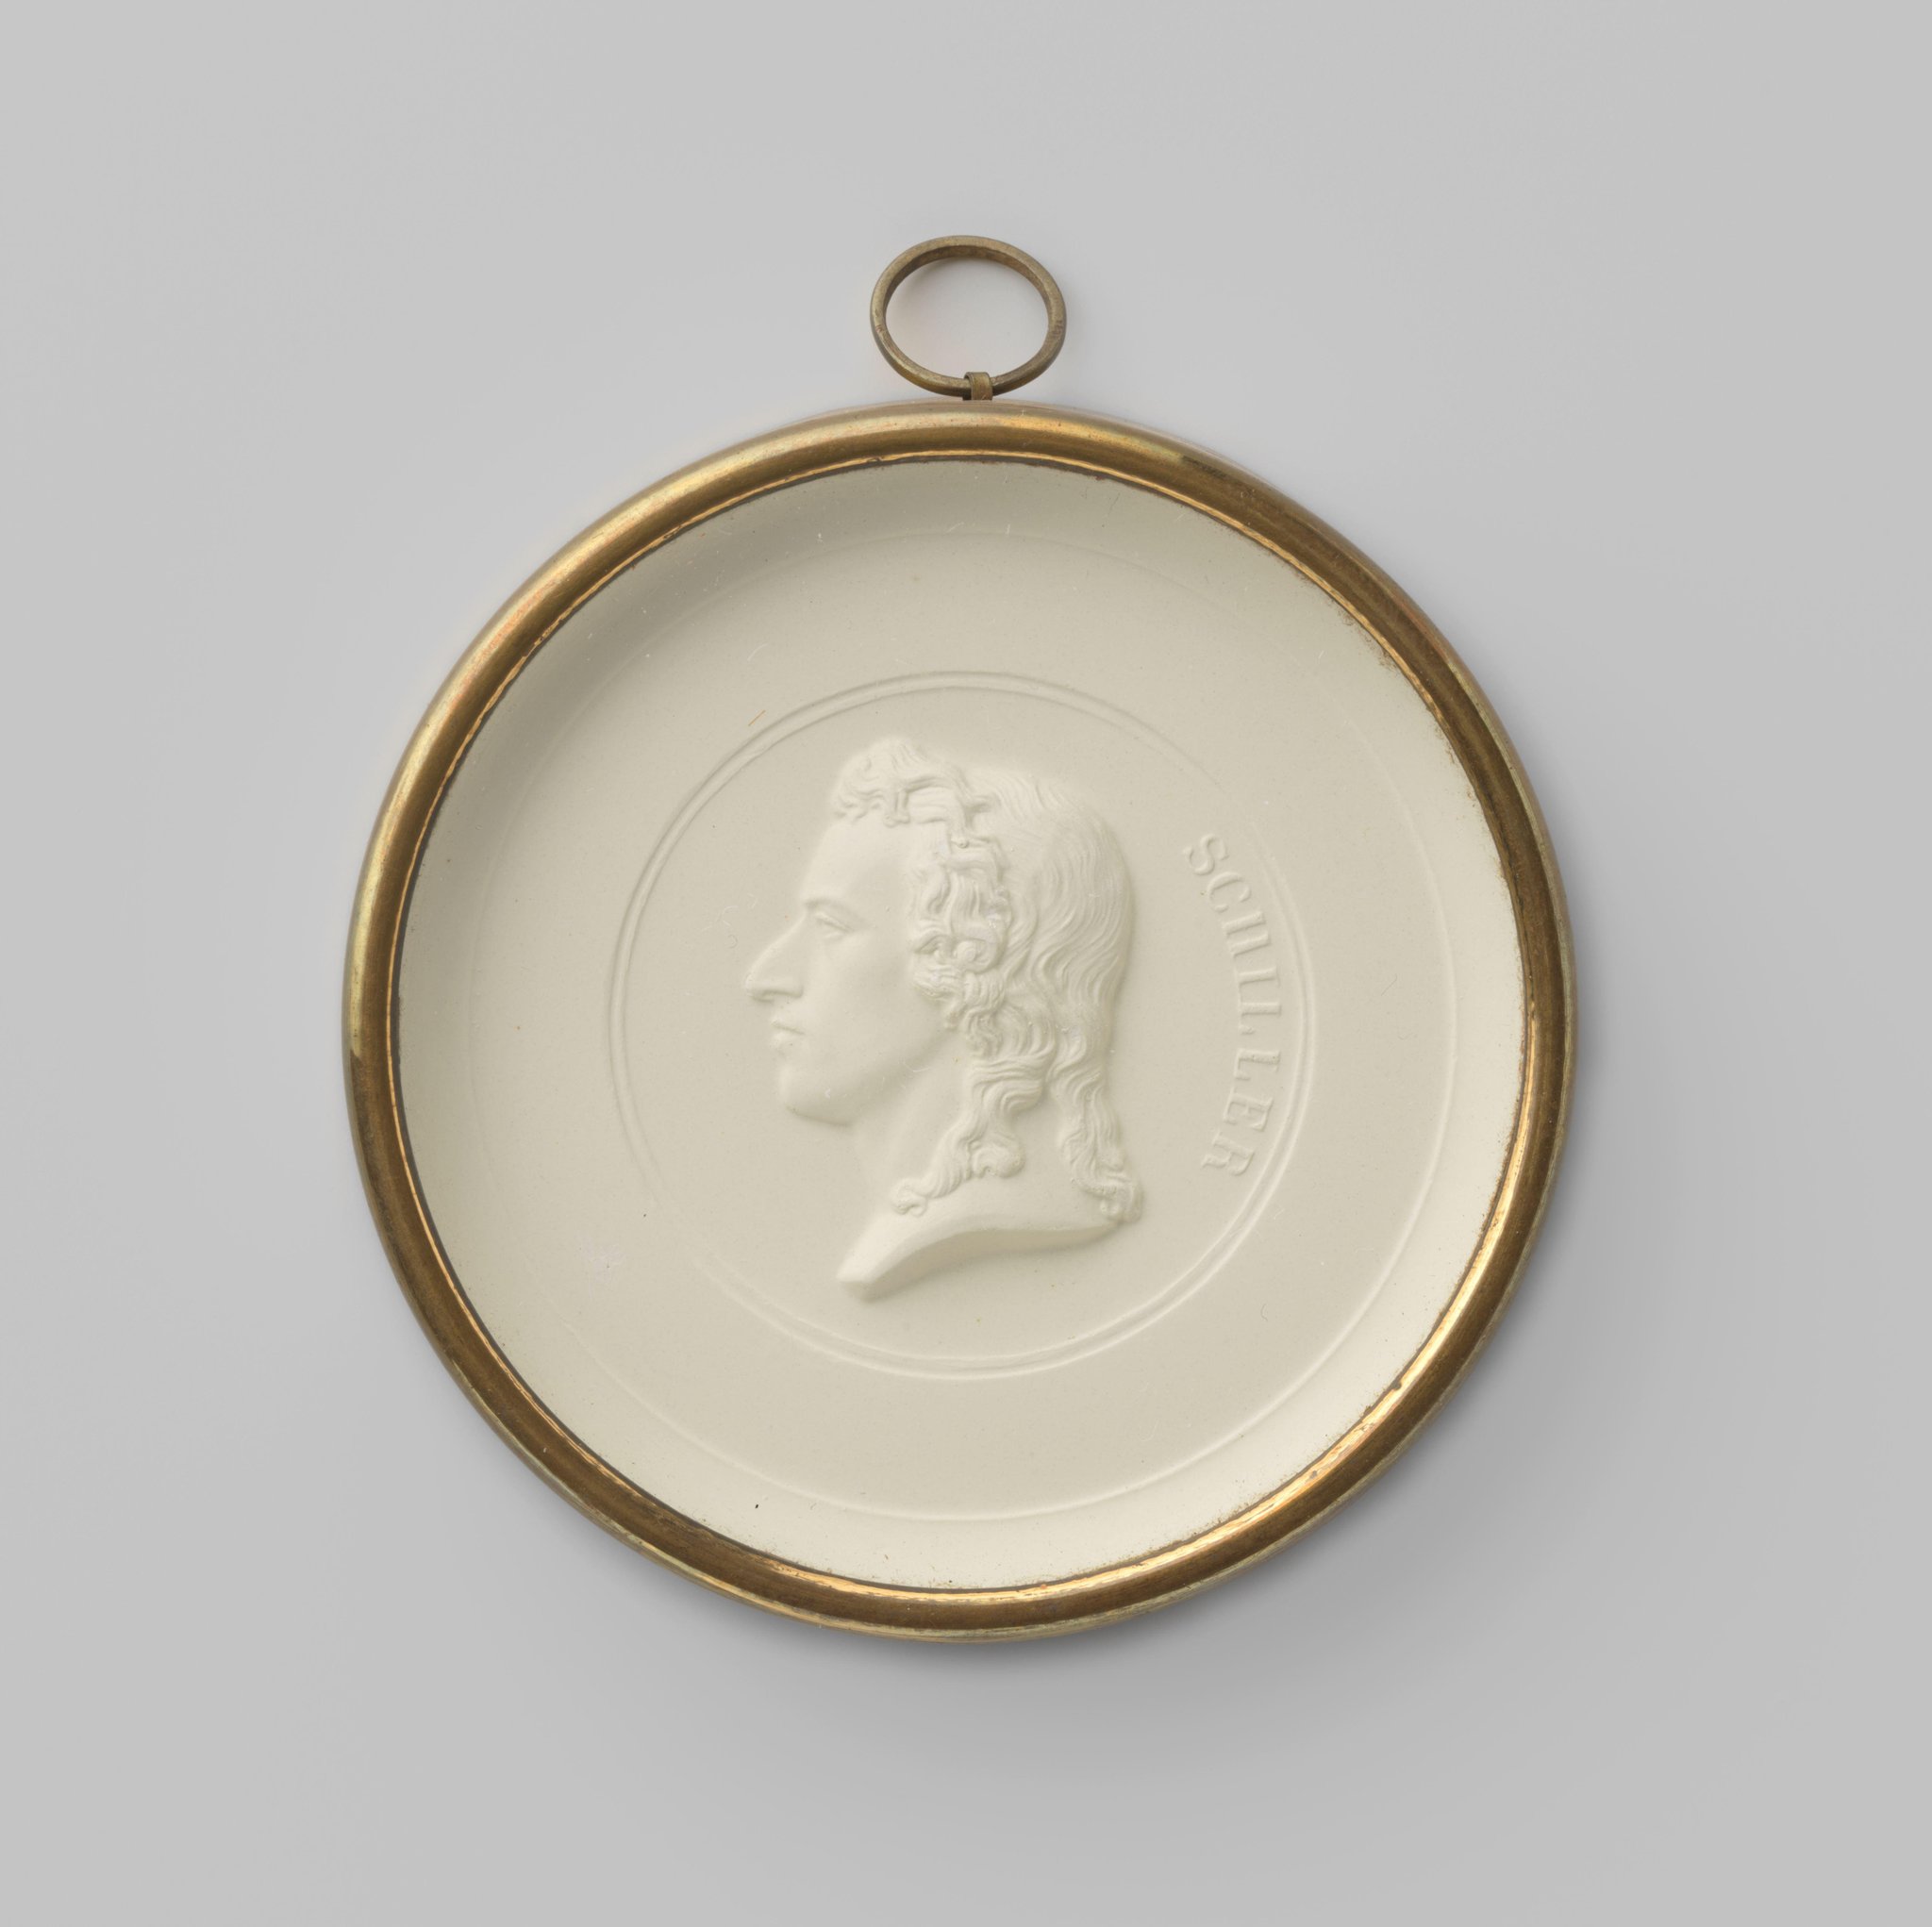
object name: locket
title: Friedrich Schiller, Duits literator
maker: gottfried eichler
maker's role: draughtsman, painter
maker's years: 1677-1757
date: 1687-1757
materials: brass, glass, gypsum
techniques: casting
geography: berlin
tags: friedrich von schiller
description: Eenzijdig medaillon in messing ring achter glas aan draagoog en draagring. Voorzijde: borststuk man naar rechts binnen omschrift. Keerzijde: etiket met opschrift.